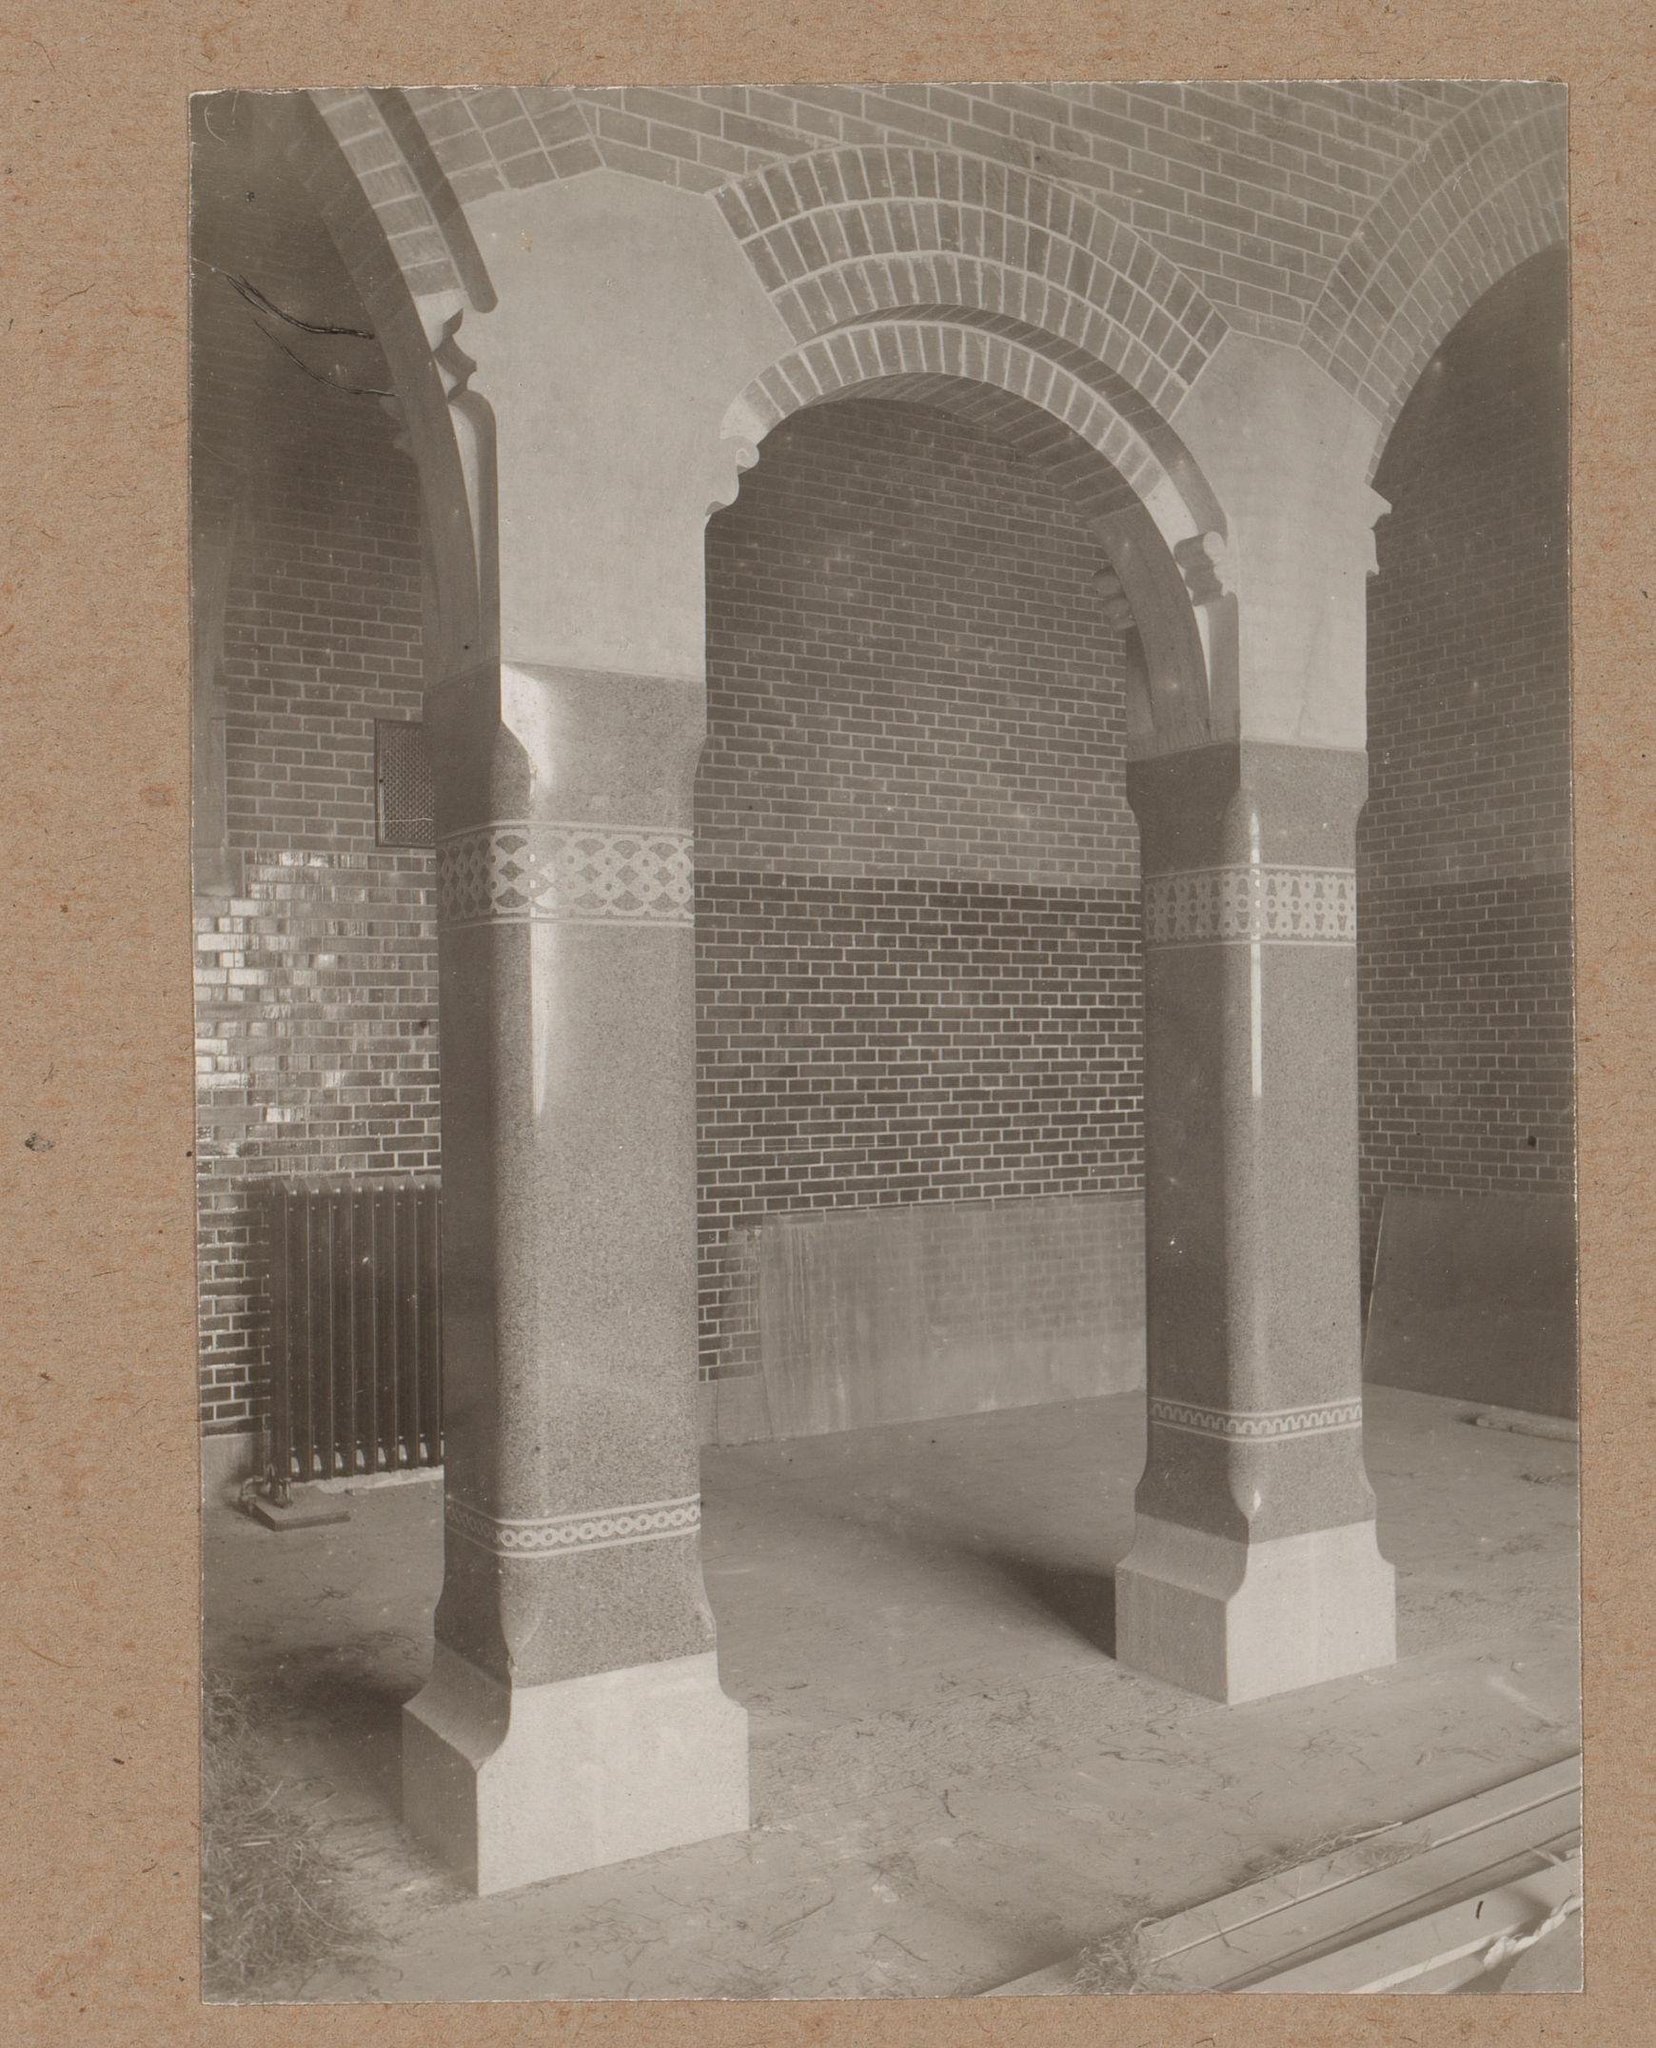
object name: photograph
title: Zuilen in de Beurs van Berlage te Amsterdam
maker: Anonymous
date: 1903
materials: paper, cardboard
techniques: gelatin silver print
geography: amsterdam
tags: column, pillar ~ architecture, stock exchange, stock-market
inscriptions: stamp: ‘Rijksmuseum/ Amsterdam’